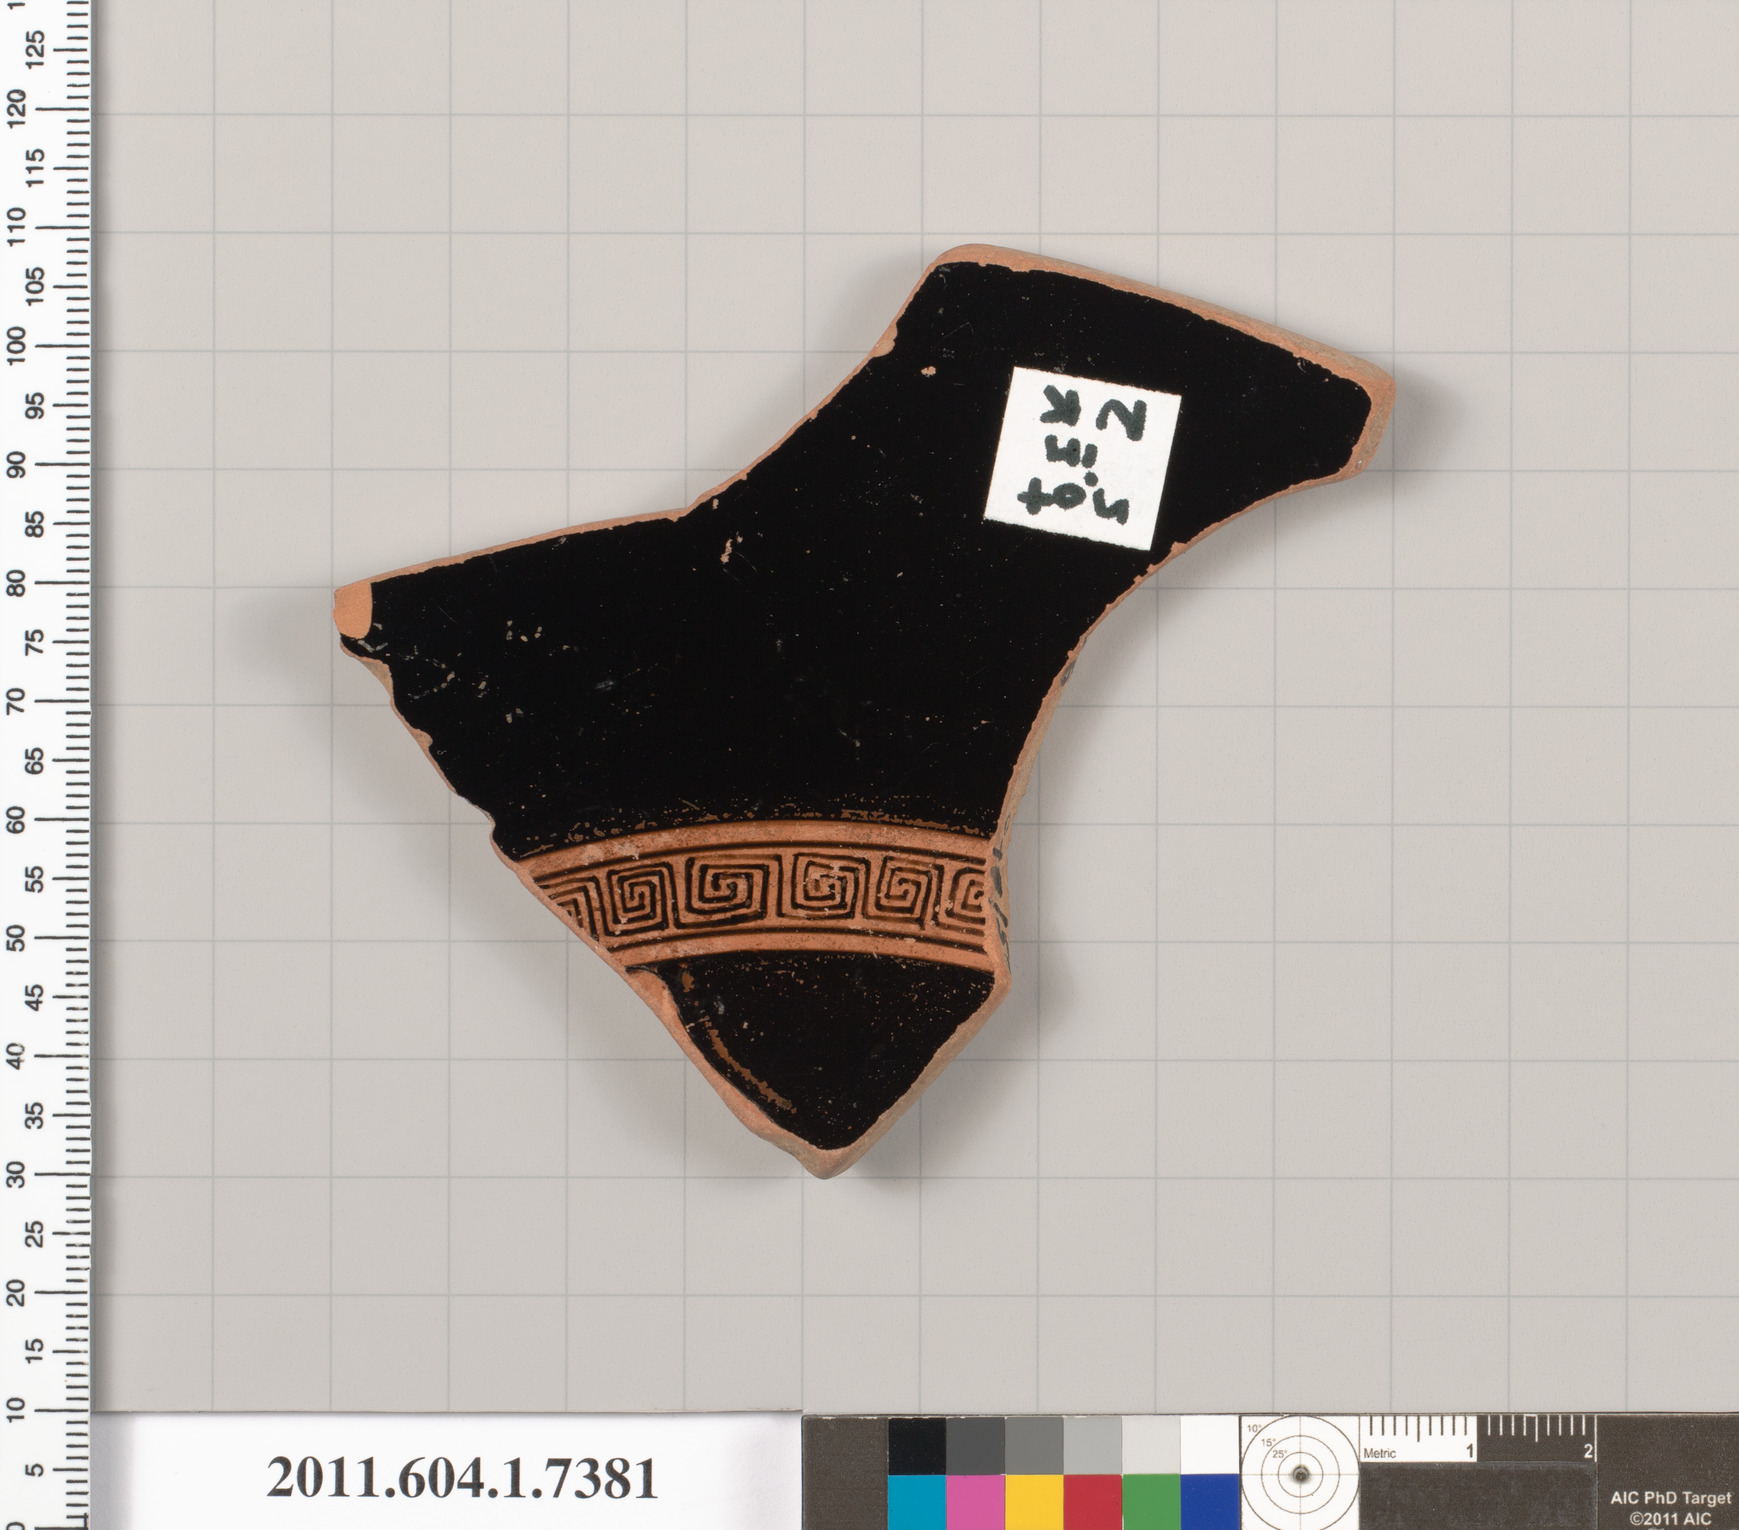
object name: kylix fragment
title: Terracotta fragment of a kylix (drinking cup)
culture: greek, attic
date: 500-480 BCE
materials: terracotta